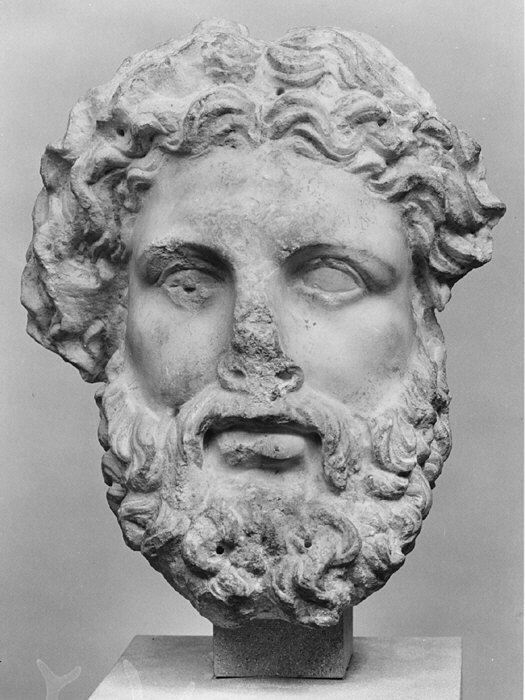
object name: head of zeus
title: Marble head of a god, probably Zeus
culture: greek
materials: marble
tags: heads,zeus